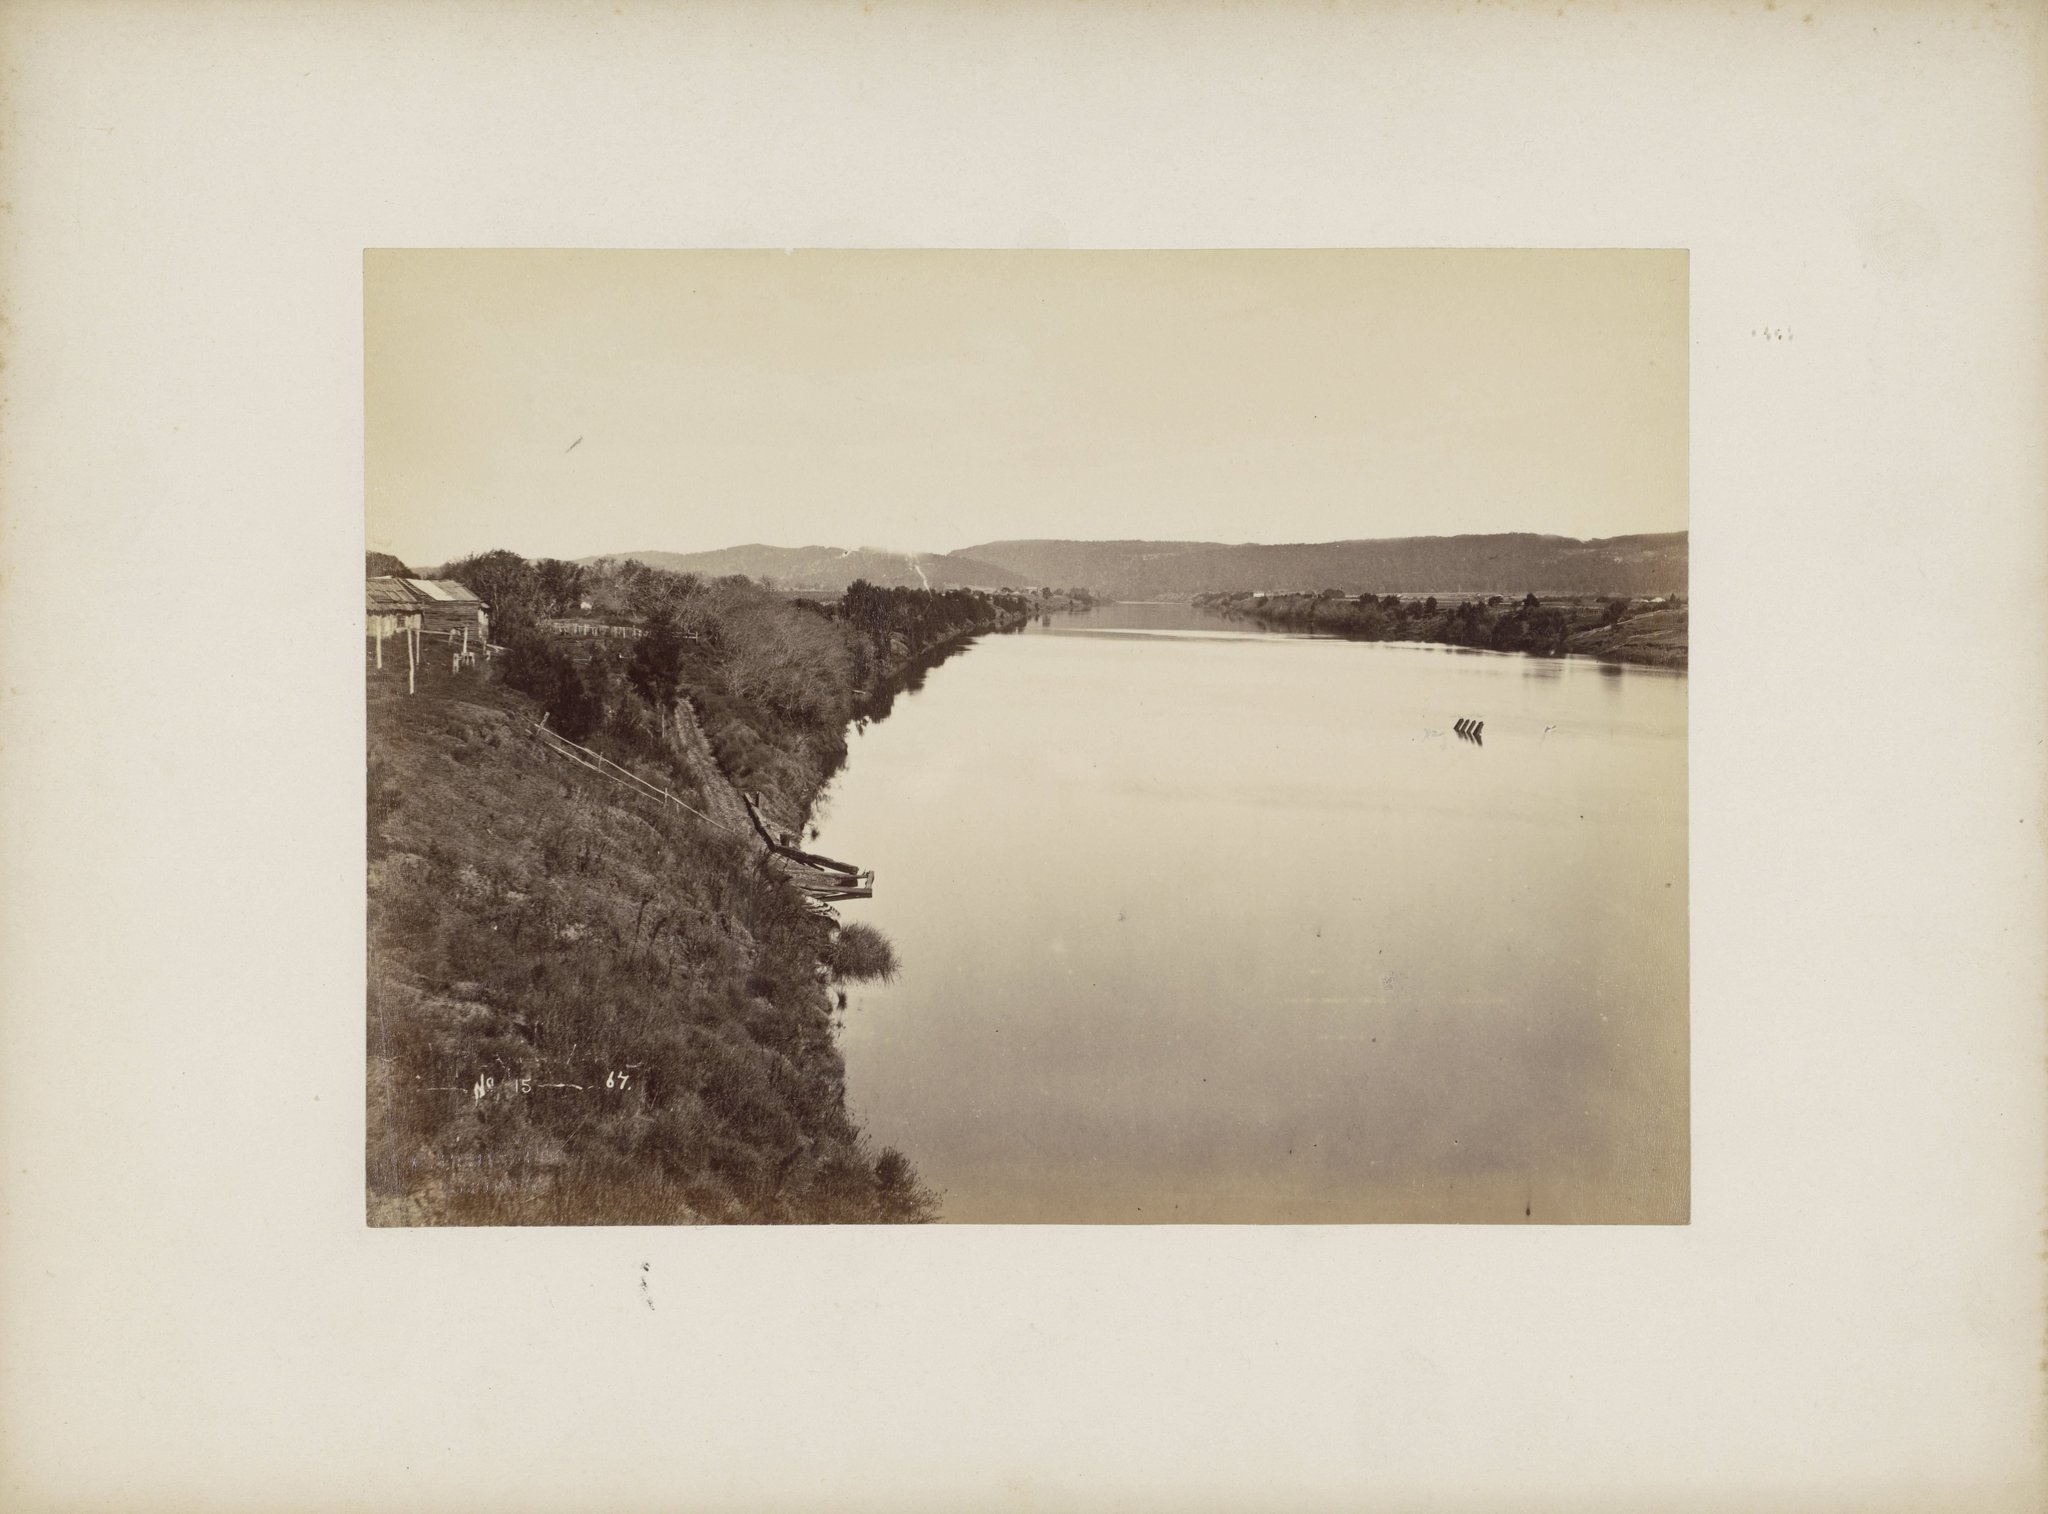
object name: photograph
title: Gezicht op een rivier en oevers, vermoedelijk in de buurt van Sydney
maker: charles bayliss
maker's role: fotograaf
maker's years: 1850-1897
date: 1890-1910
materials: cardboard, paper, photographic support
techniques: albumen print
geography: sydney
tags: river (+ landscape with figures, staffage)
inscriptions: number: ‘No. 15 ---- 67.’, check stamp: ‘C. Bayliss Photo Sydney’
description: Onderdeel van Reisalbum met foto's van bezienswaardigheden in Sydney.